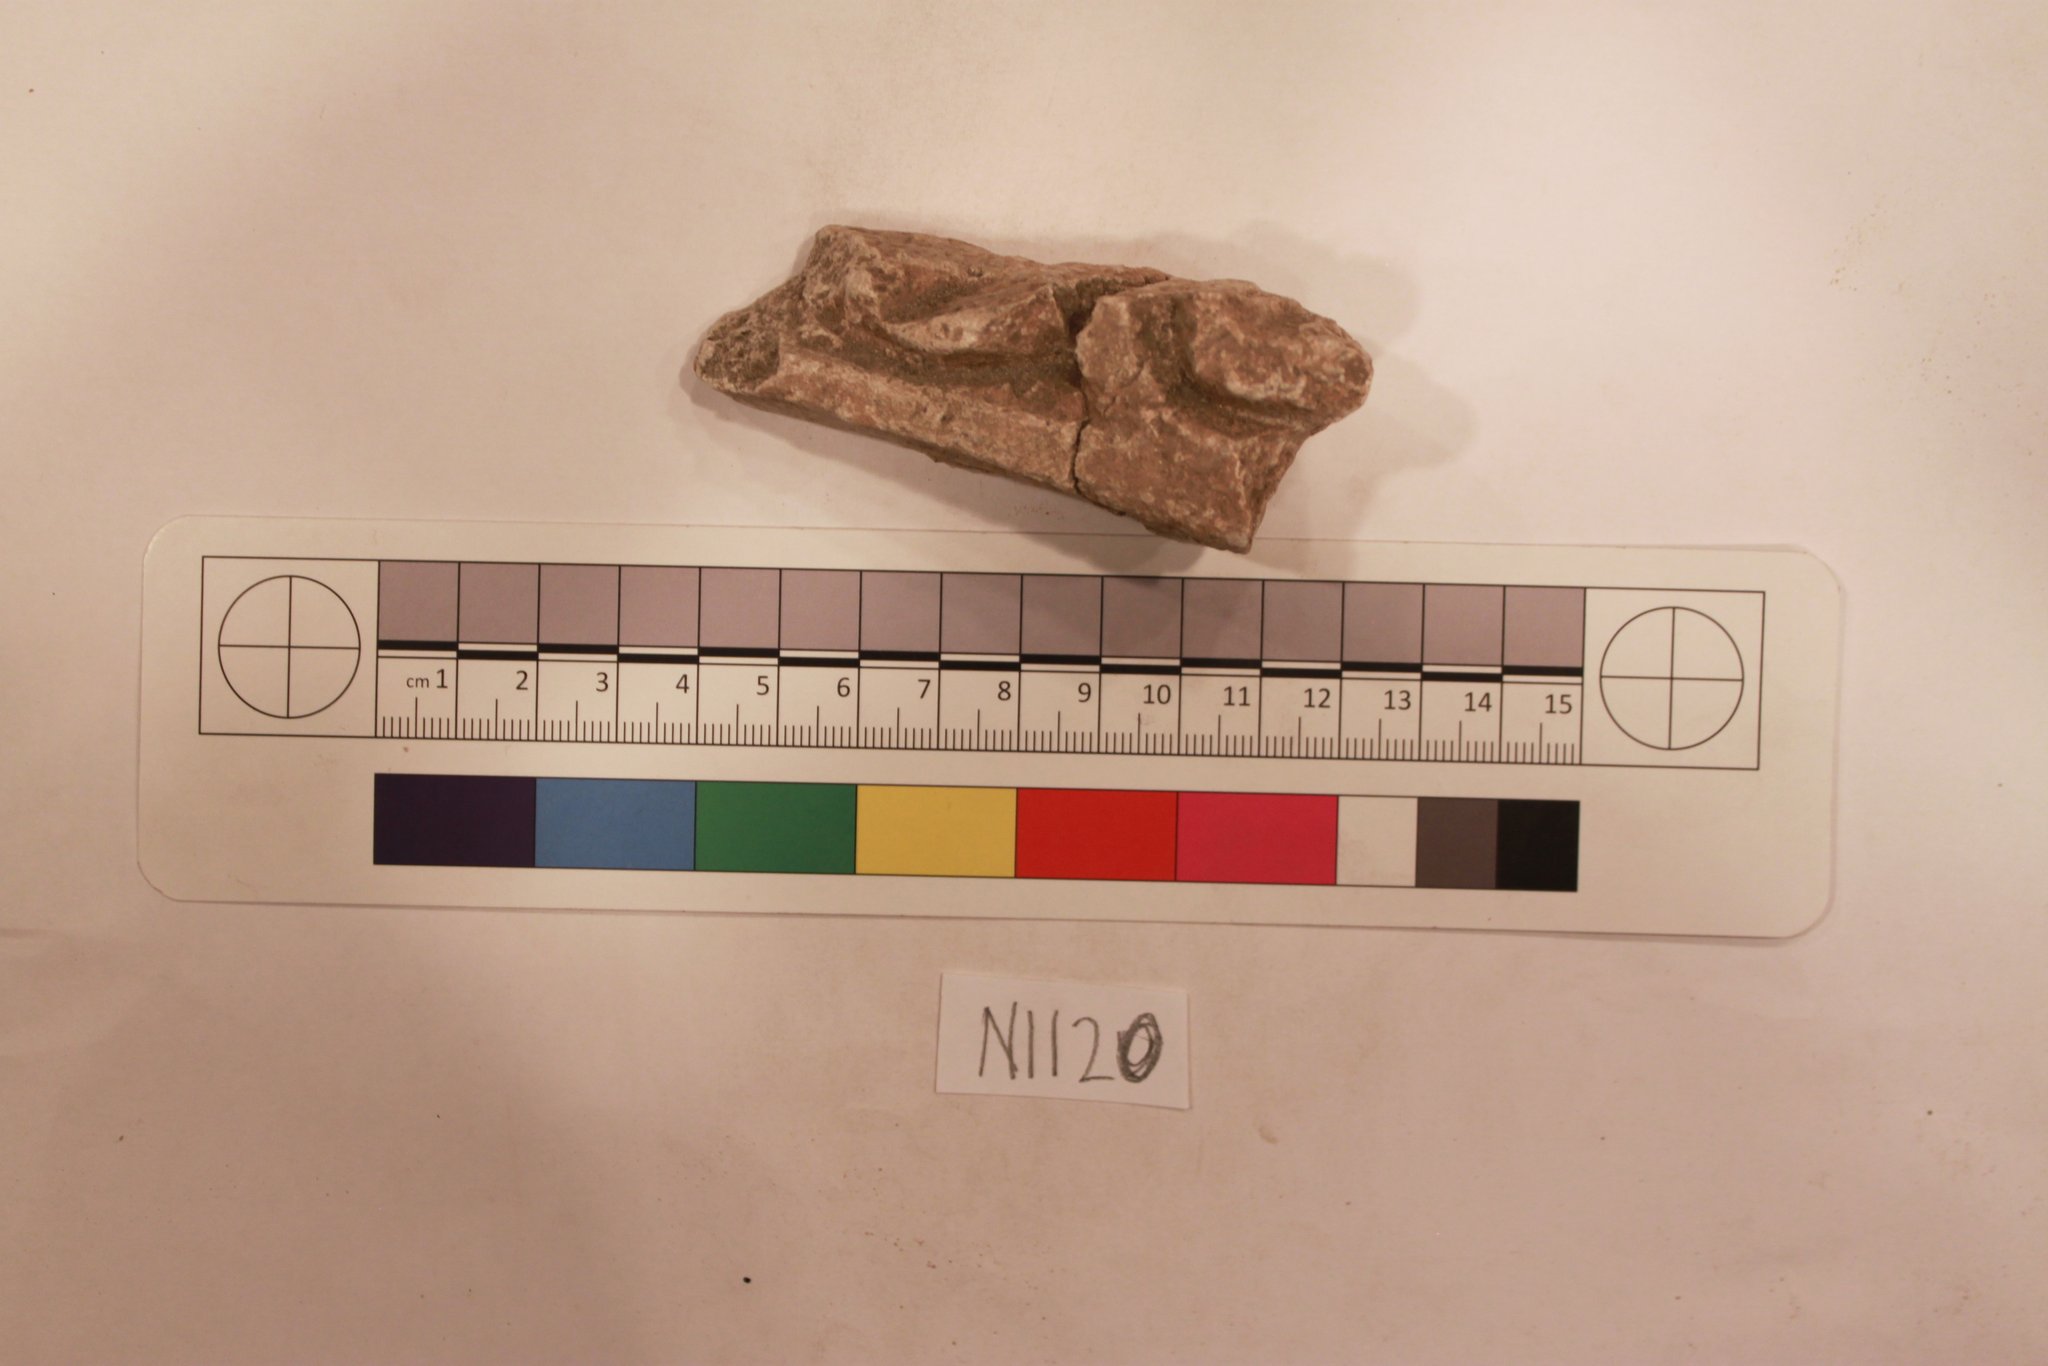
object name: fragment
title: Stucco Fragment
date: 701-1200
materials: plaster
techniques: carving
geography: iran